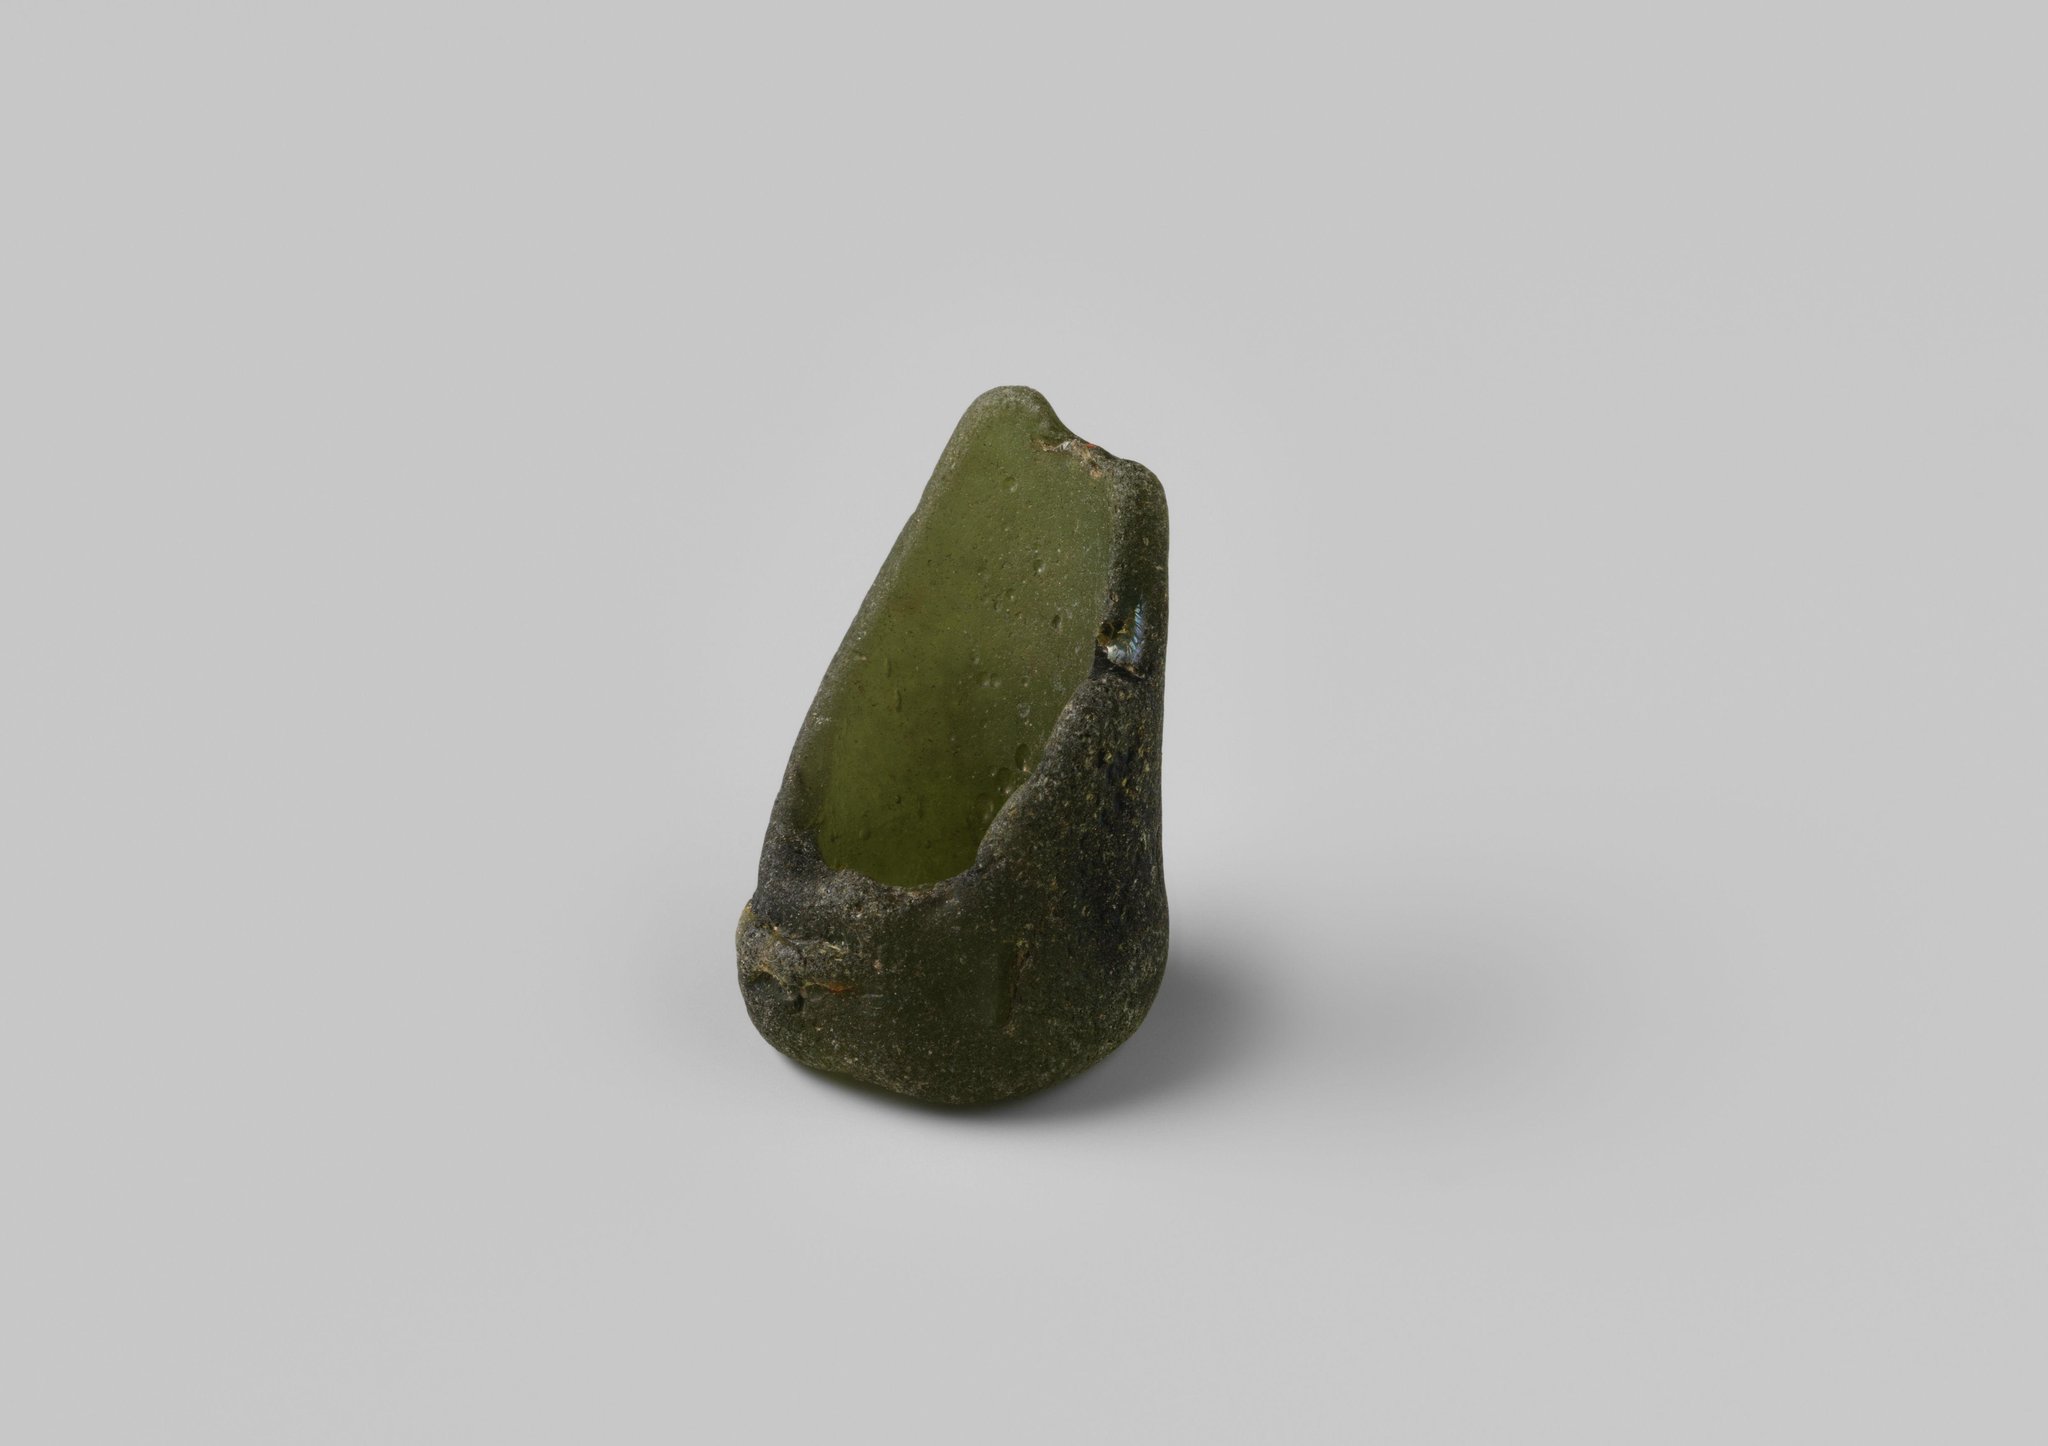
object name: sherd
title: Scherf van een wijnfles uit het wrak van de Oostindiëvaarder Hollandia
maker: Anonymous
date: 1700-1743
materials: glass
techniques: green glass